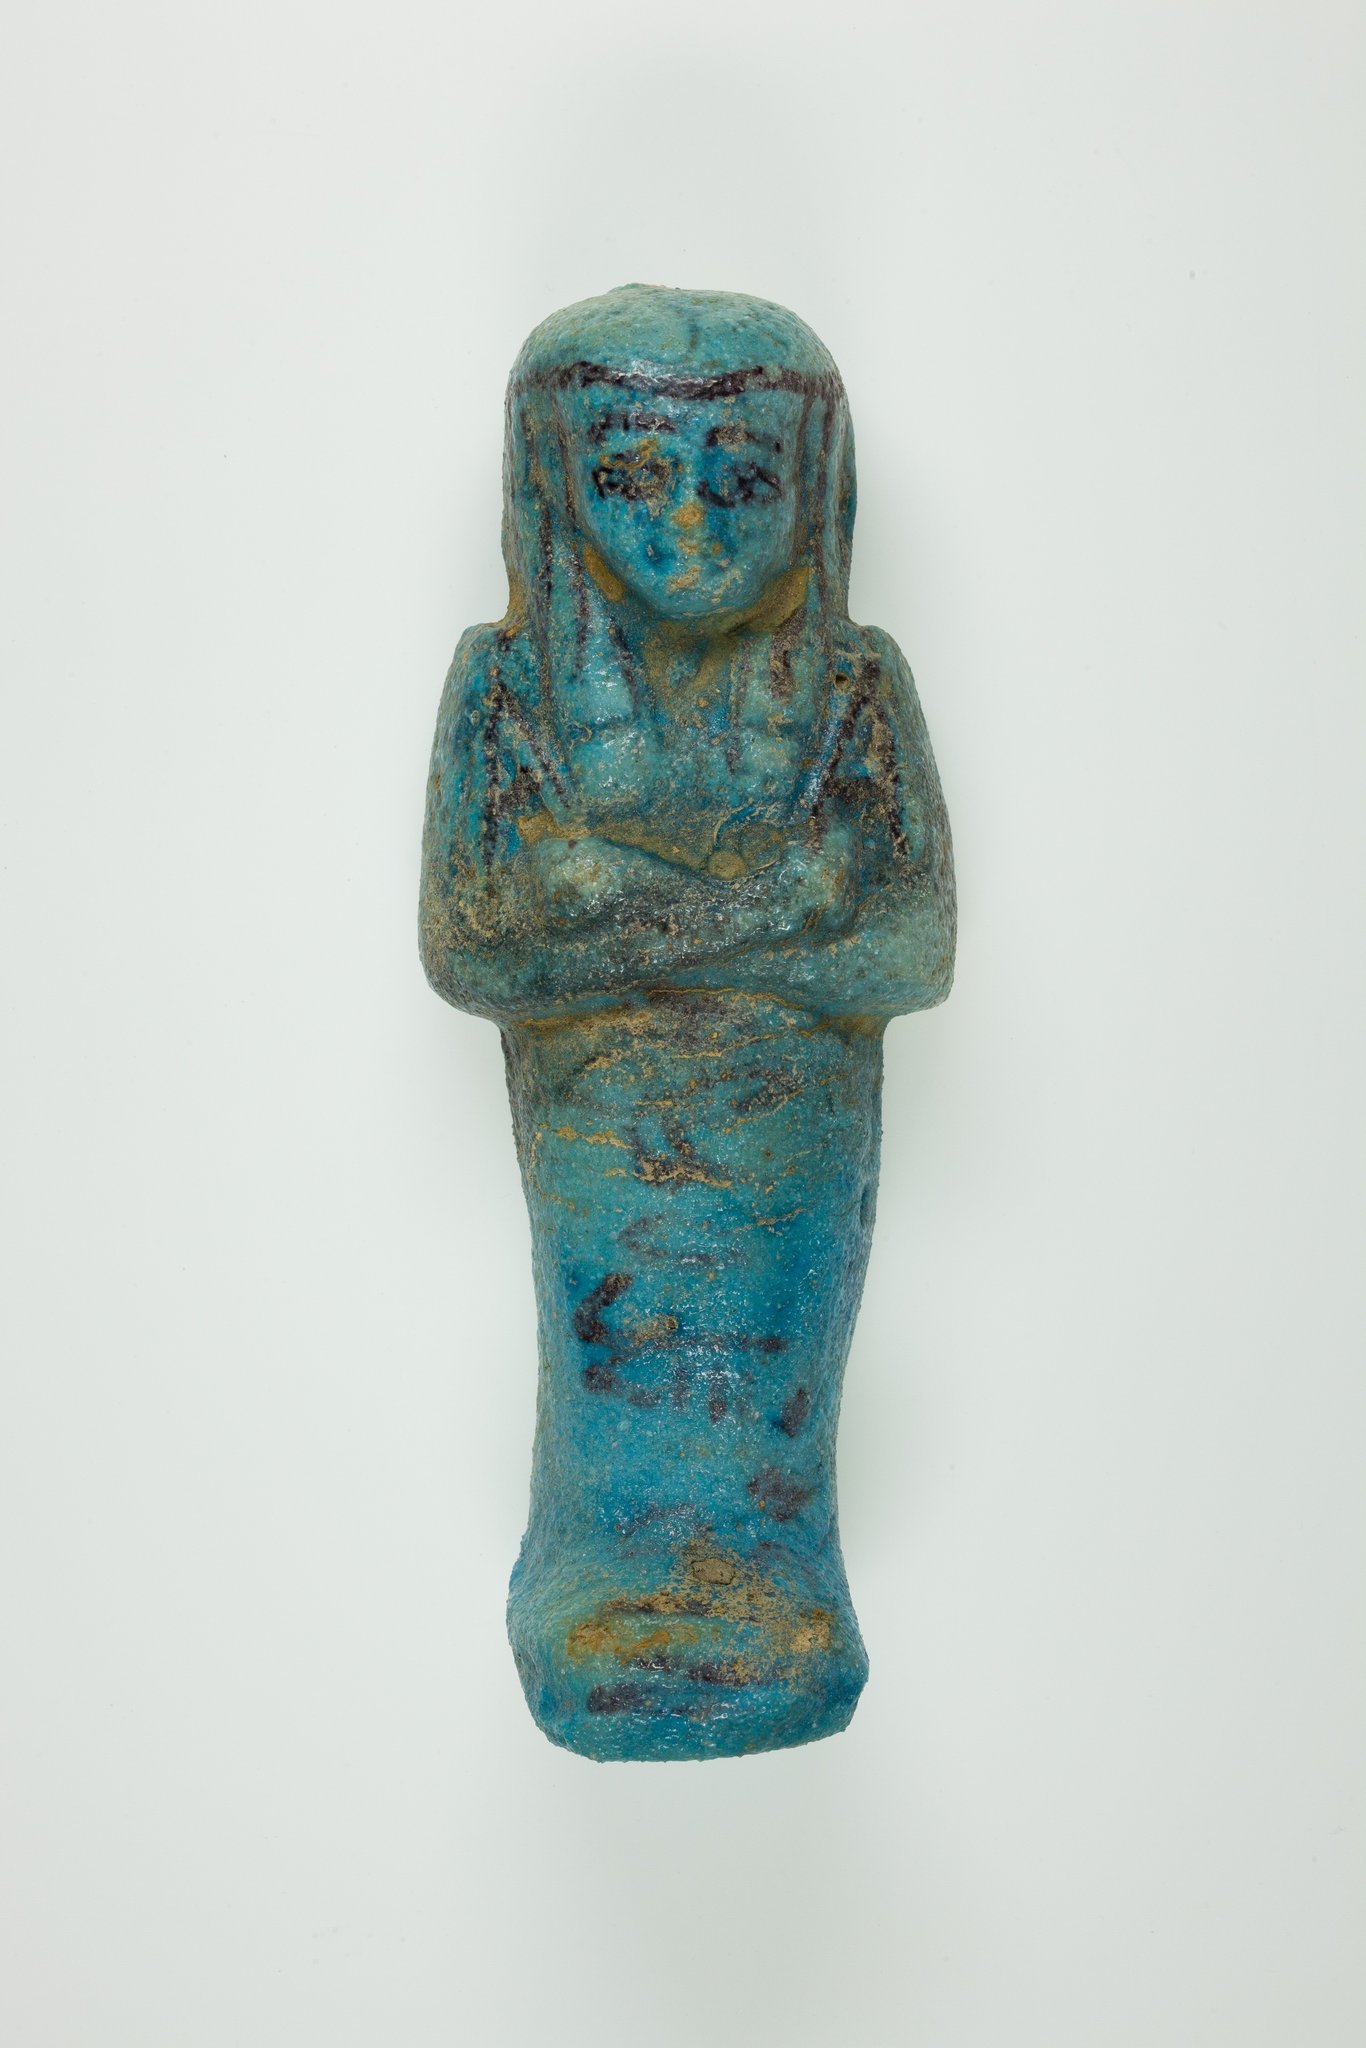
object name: worker shabti, henettawy c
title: Worker Shabti of Henettawy (C), Daughter of Isetemkheb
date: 990-970 BCE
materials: faience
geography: egypt